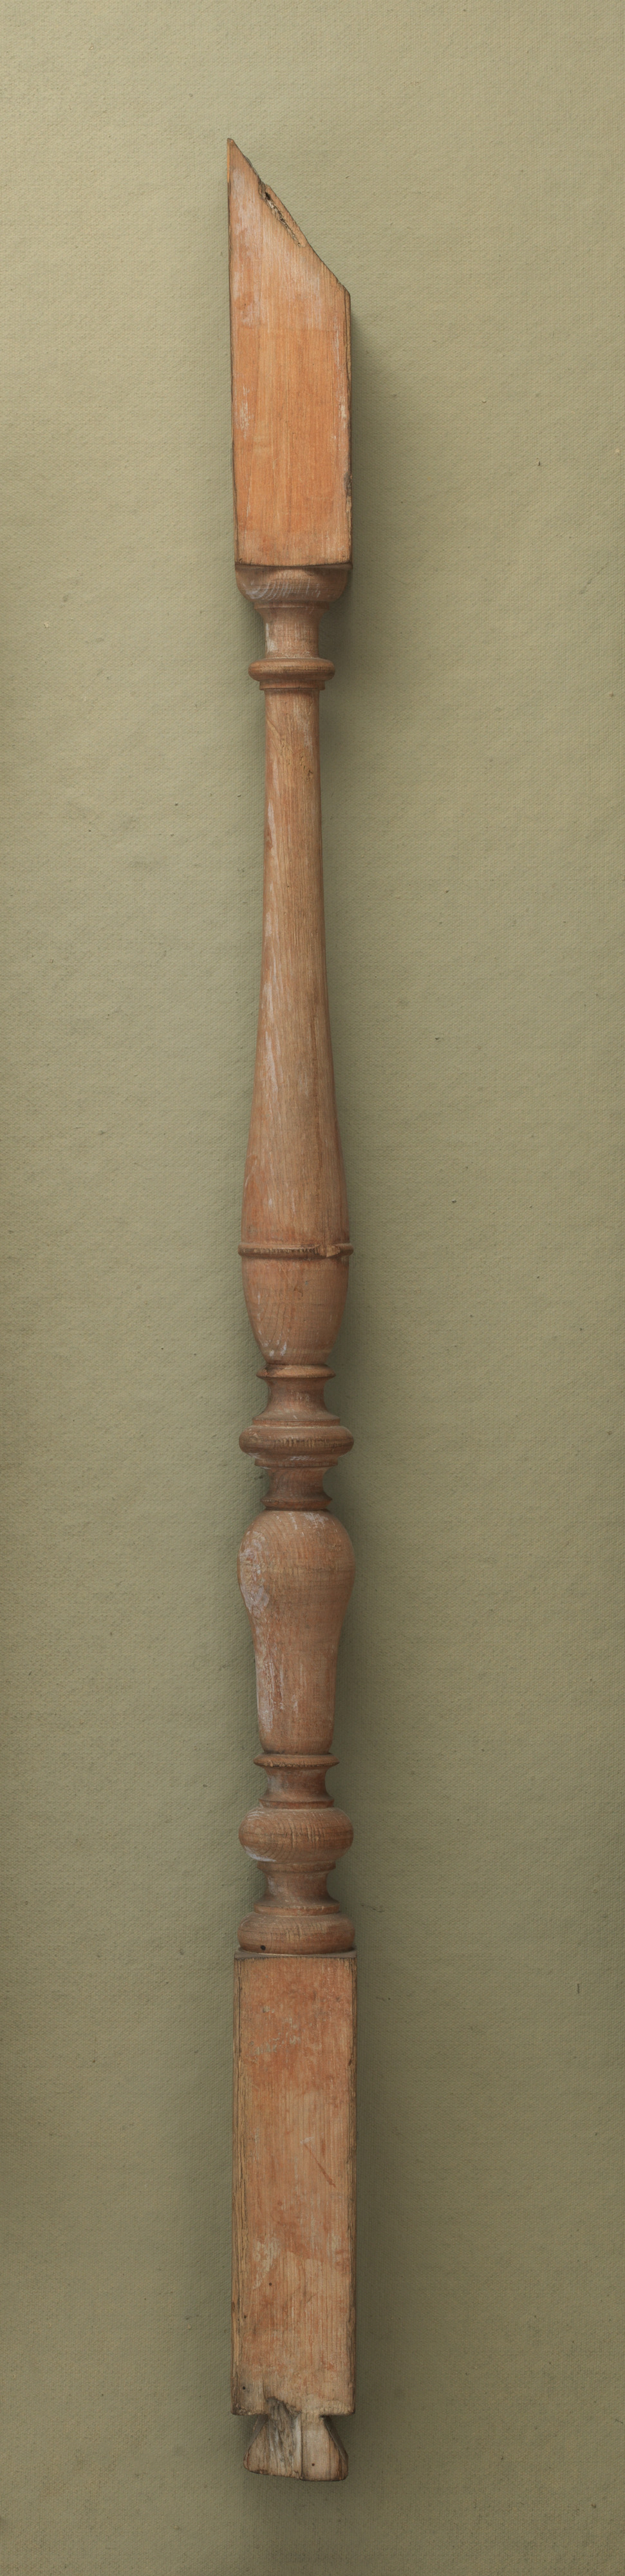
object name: baluster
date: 1701-1750